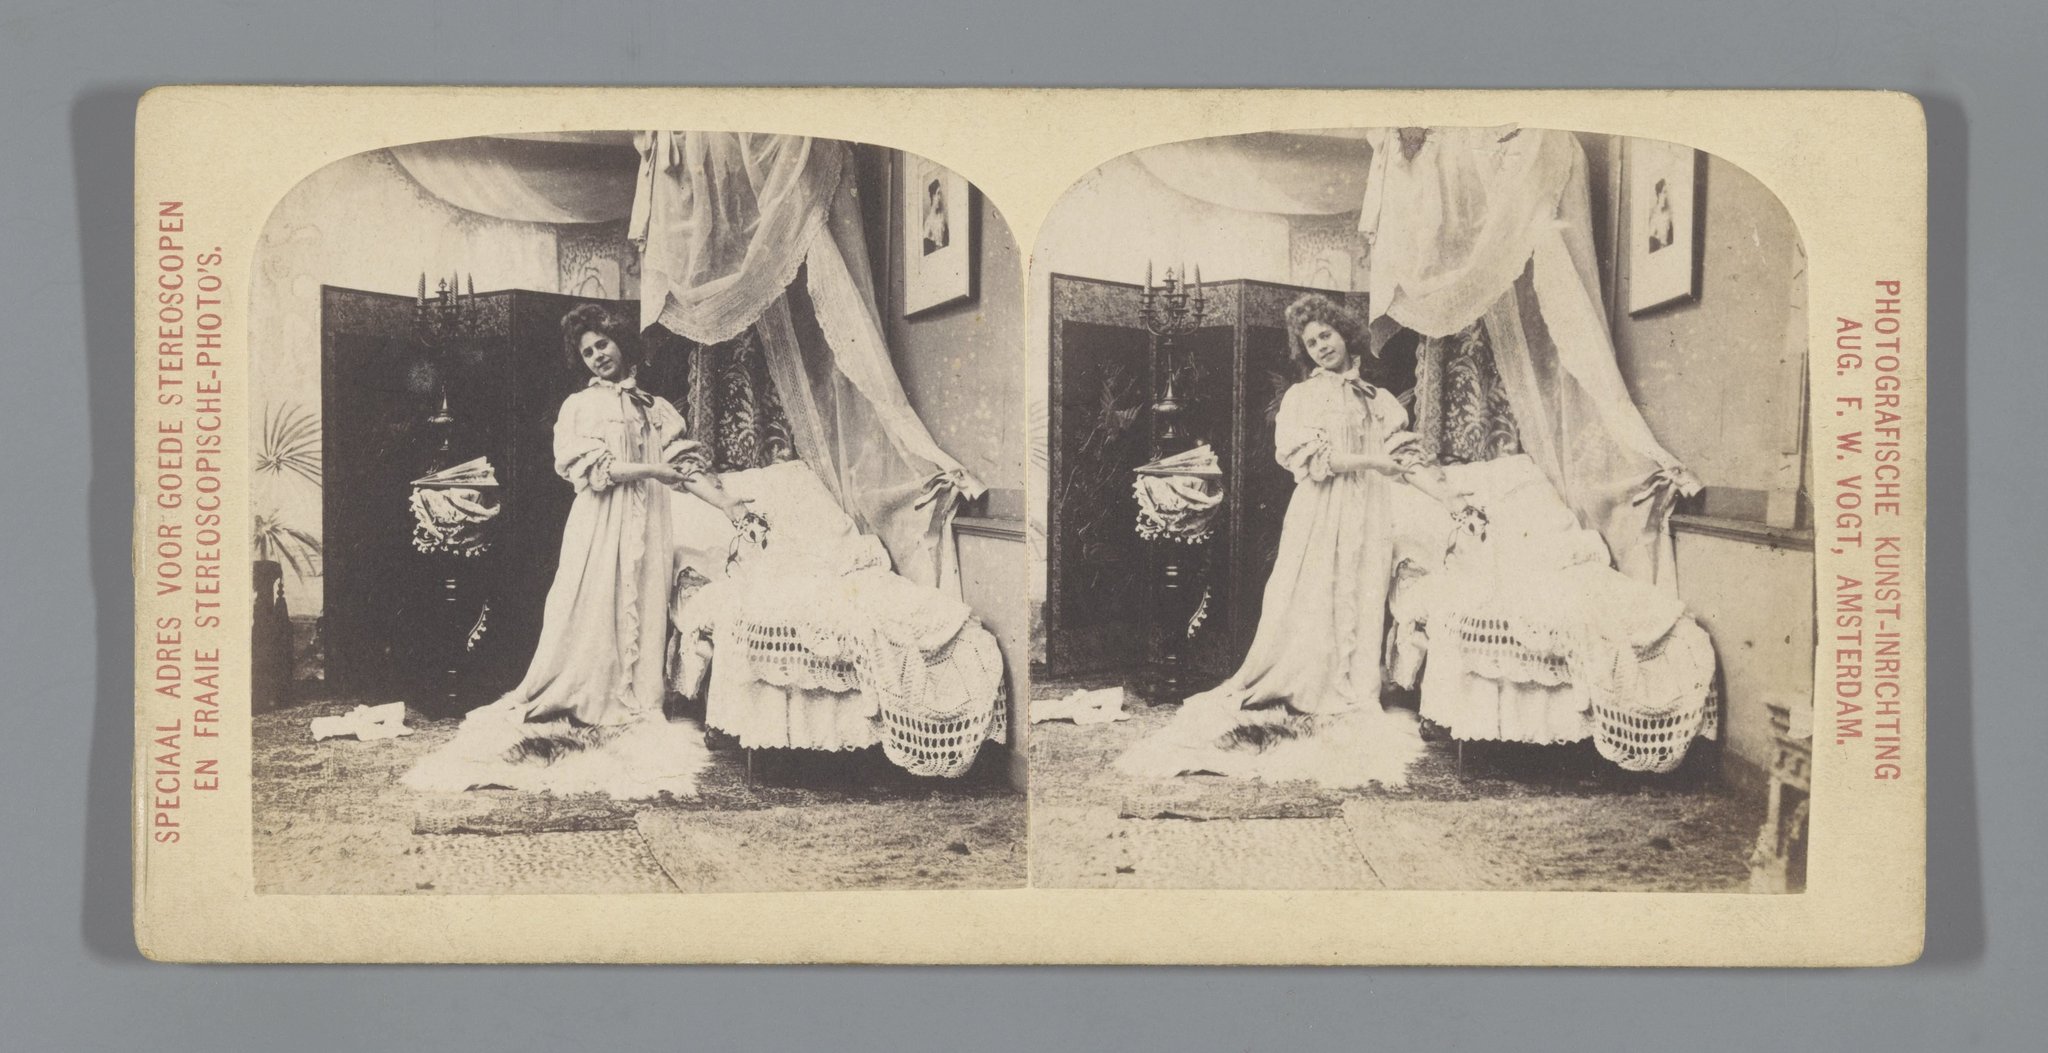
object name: stereograph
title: Jonge vrouw in slaapkamer wijst op voorwerp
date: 1870-1910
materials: cardboard, photographic support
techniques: albumen print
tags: nightwear: night-gown, screen, folding screen, bedroom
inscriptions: : ‘Photografische Kunst-inrichting, Amsterdam’, : ‘Speciaal adres voor goede stereoscopen en fraaie stereoscopische-photo's’